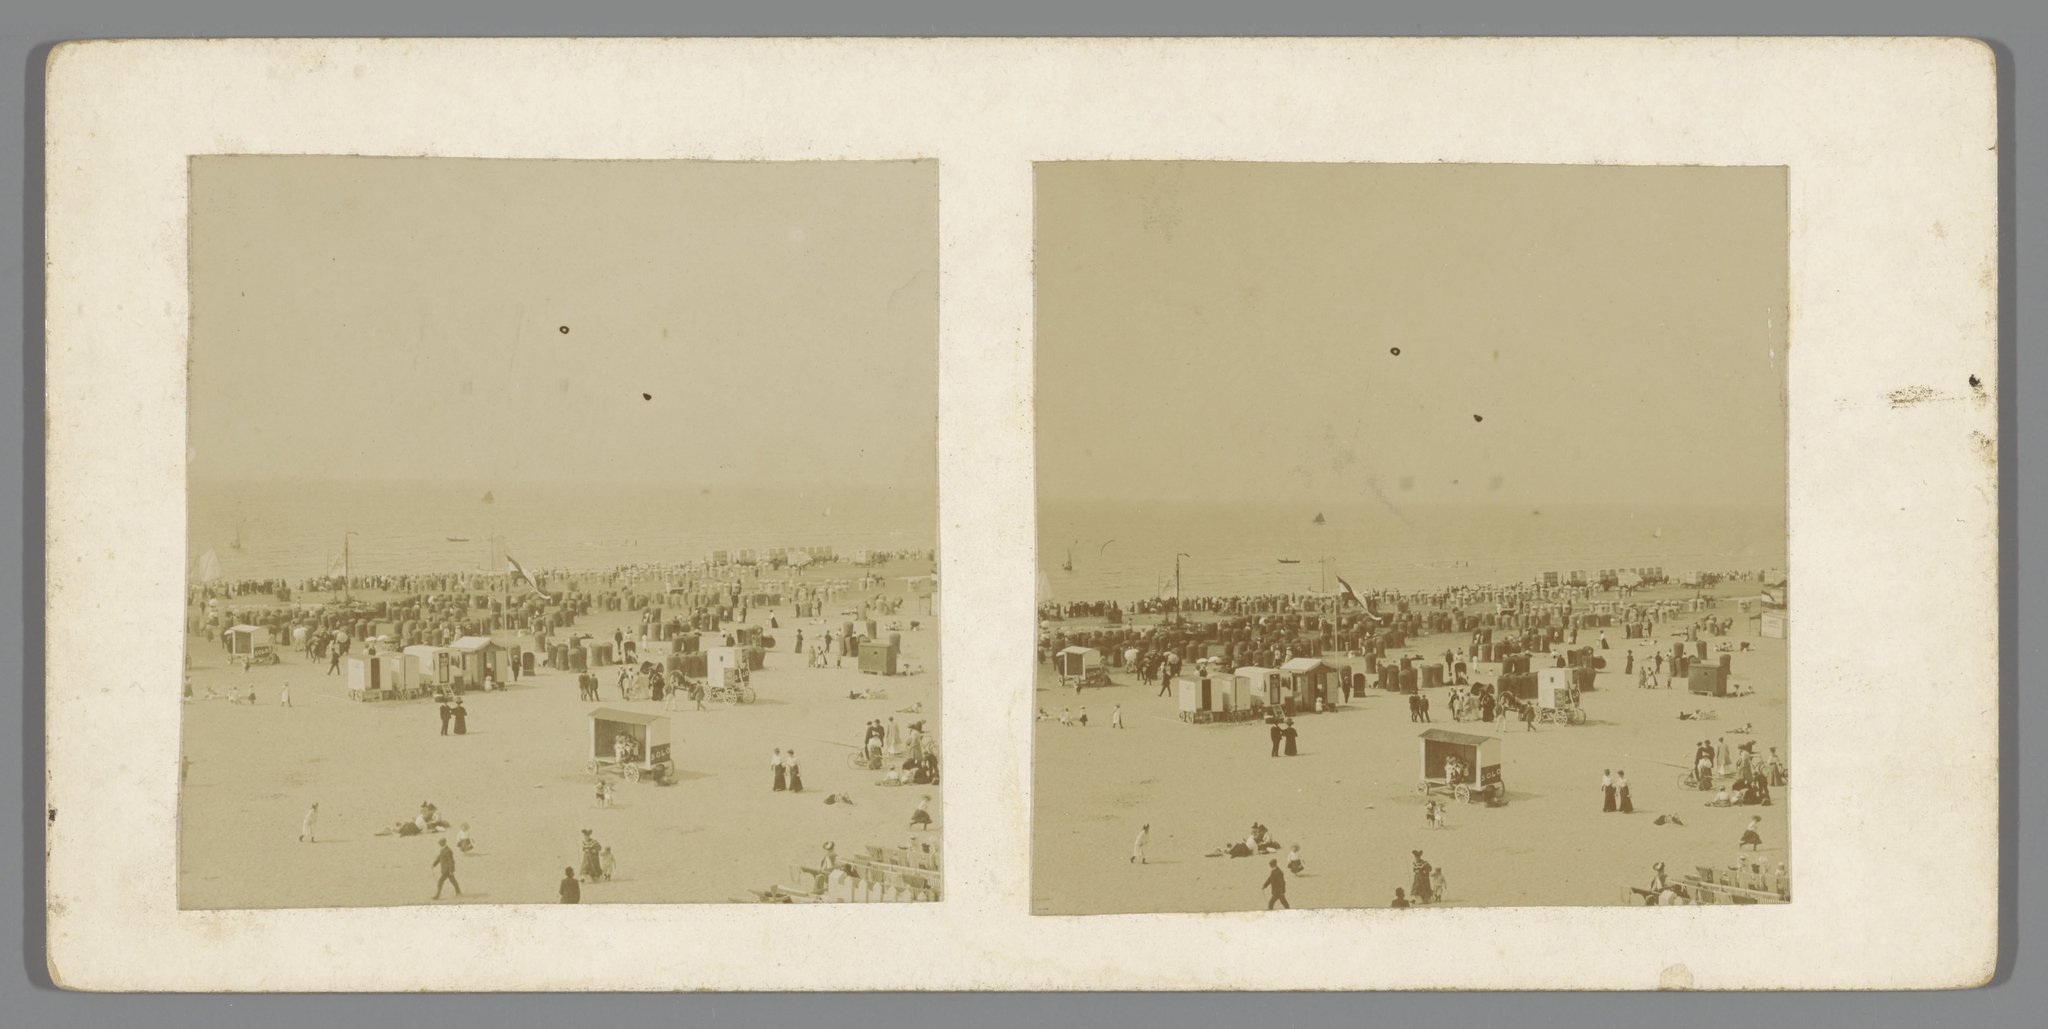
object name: stereograph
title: Strandgezicht in Zandvoort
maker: Anonymous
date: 1906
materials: paper, cardboard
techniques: collodion silver print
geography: zandvoort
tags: beach (as place of recreation), beach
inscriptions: date: ‘1906’